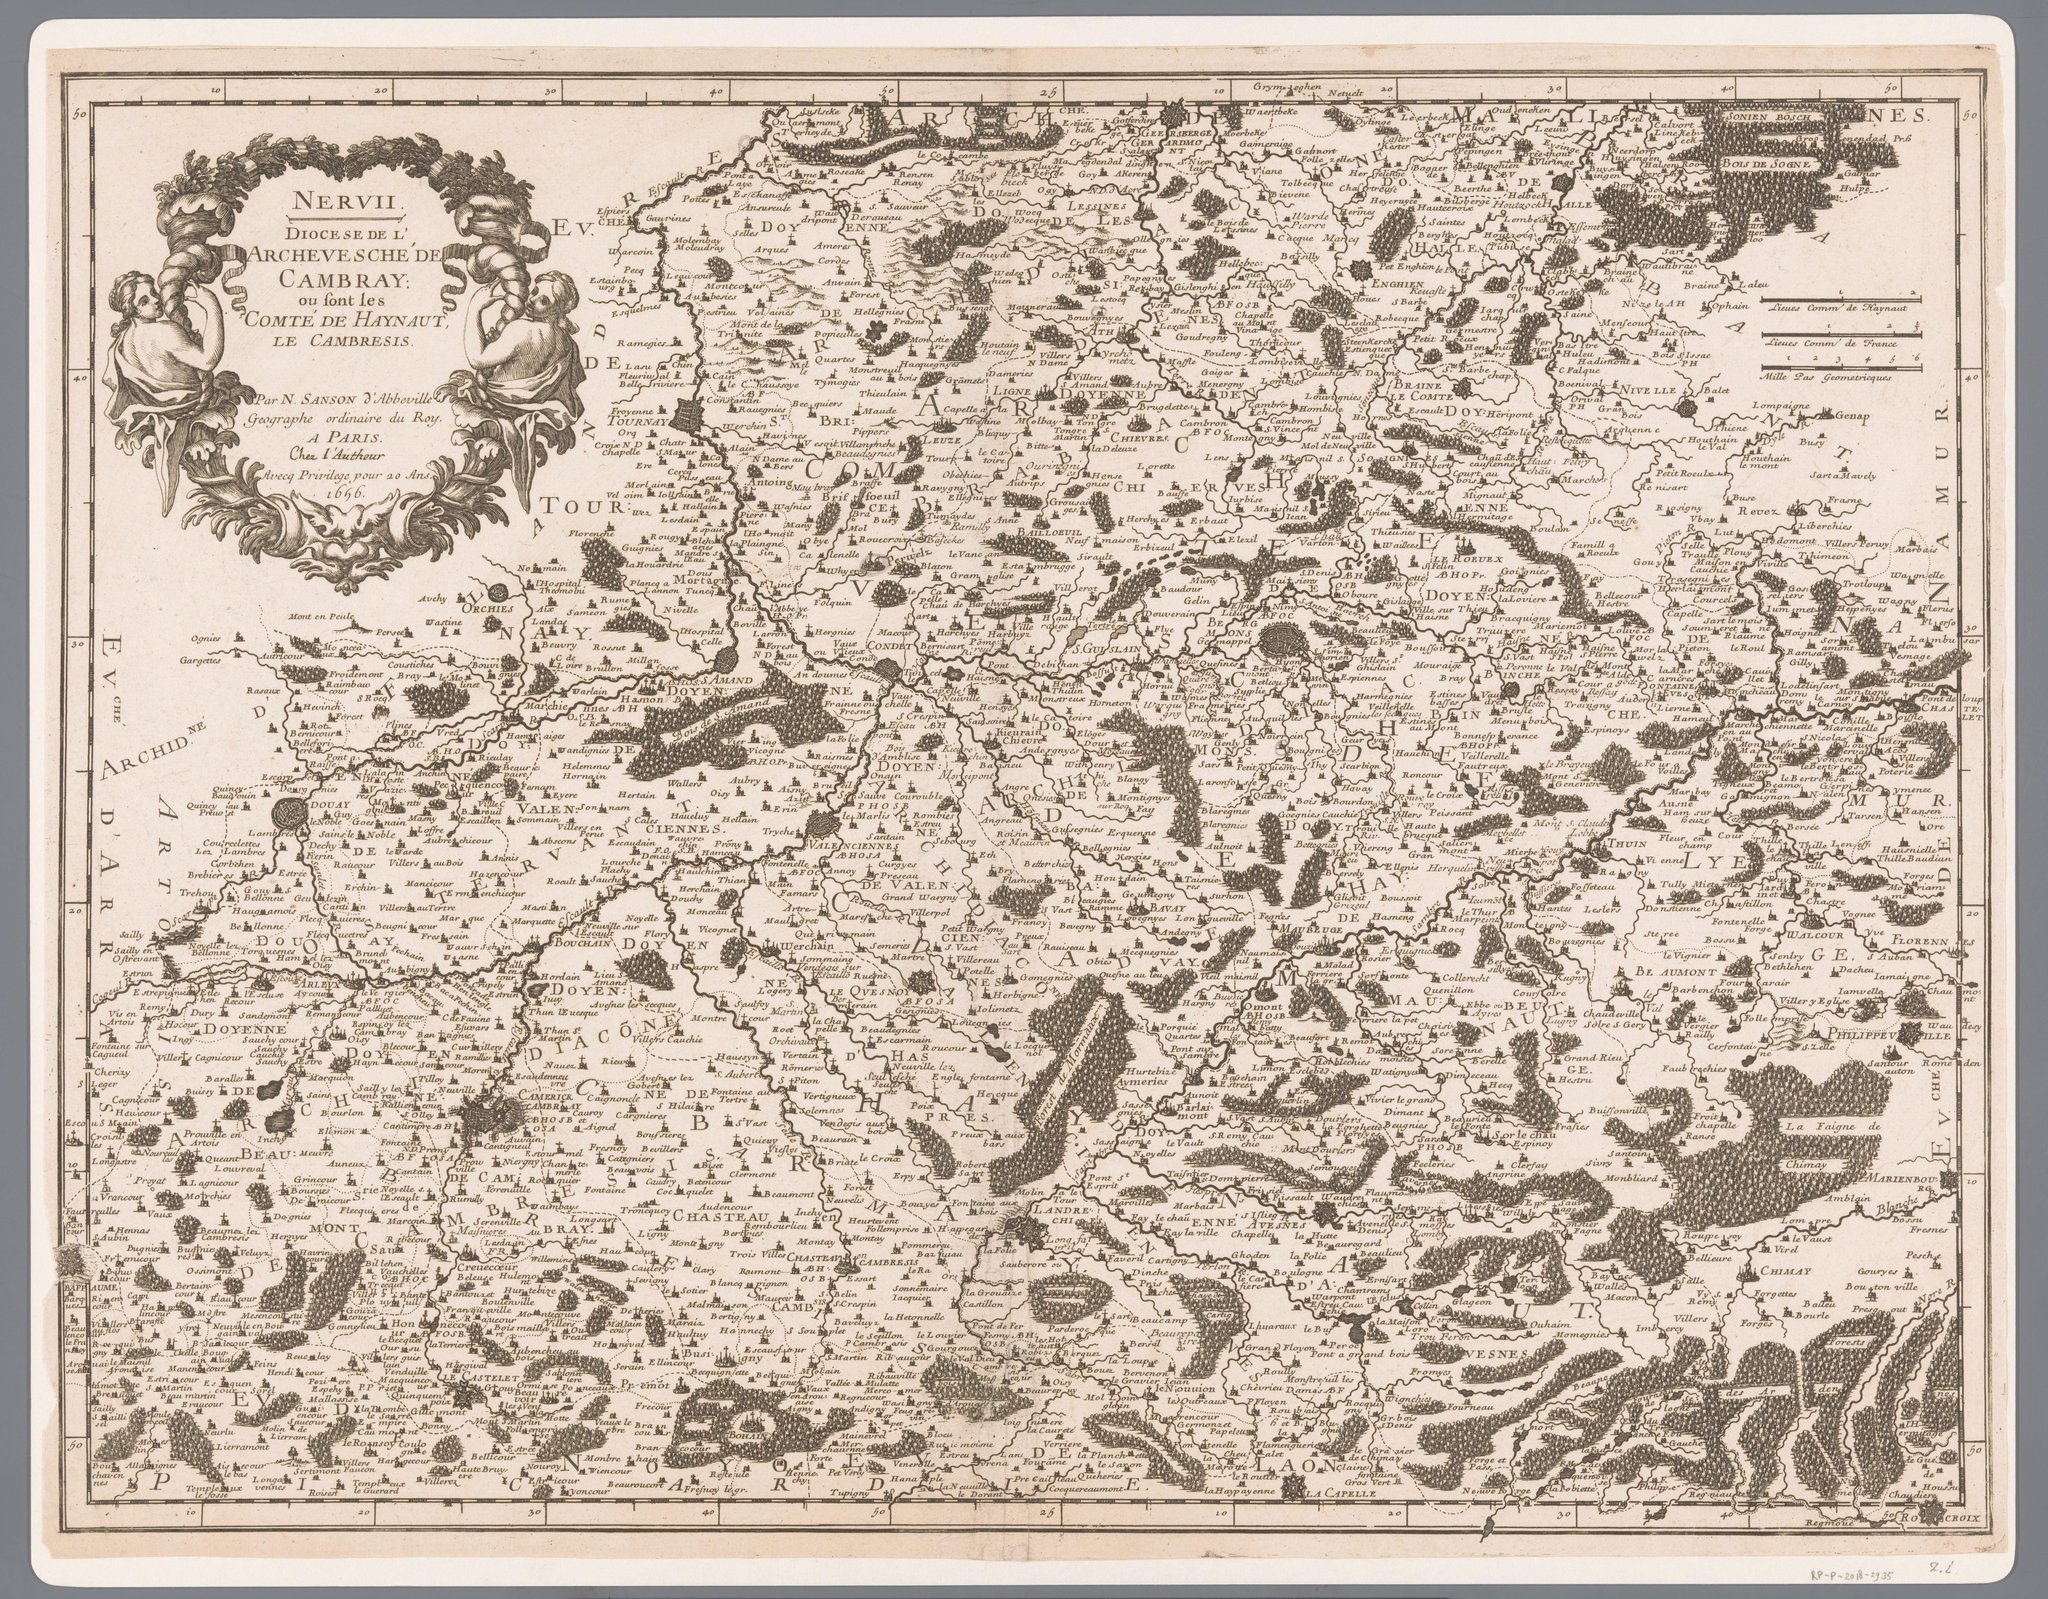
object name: print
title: Kaart van het oude gebied van de Nerviërs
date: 1656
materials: paper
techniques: engraving, etching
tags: maps of separate countries or regions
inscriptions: collector's mark: Lugt 2228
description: Kaart van het gebied van de Nerviërs, een Belgische volksstam die in het noorden van het huidige Frankrijk en het zuiden van huidig België woonde. Het gebied ligt tussen de Schelde en de Samber. Rondom de kaart een gradenverdeling.